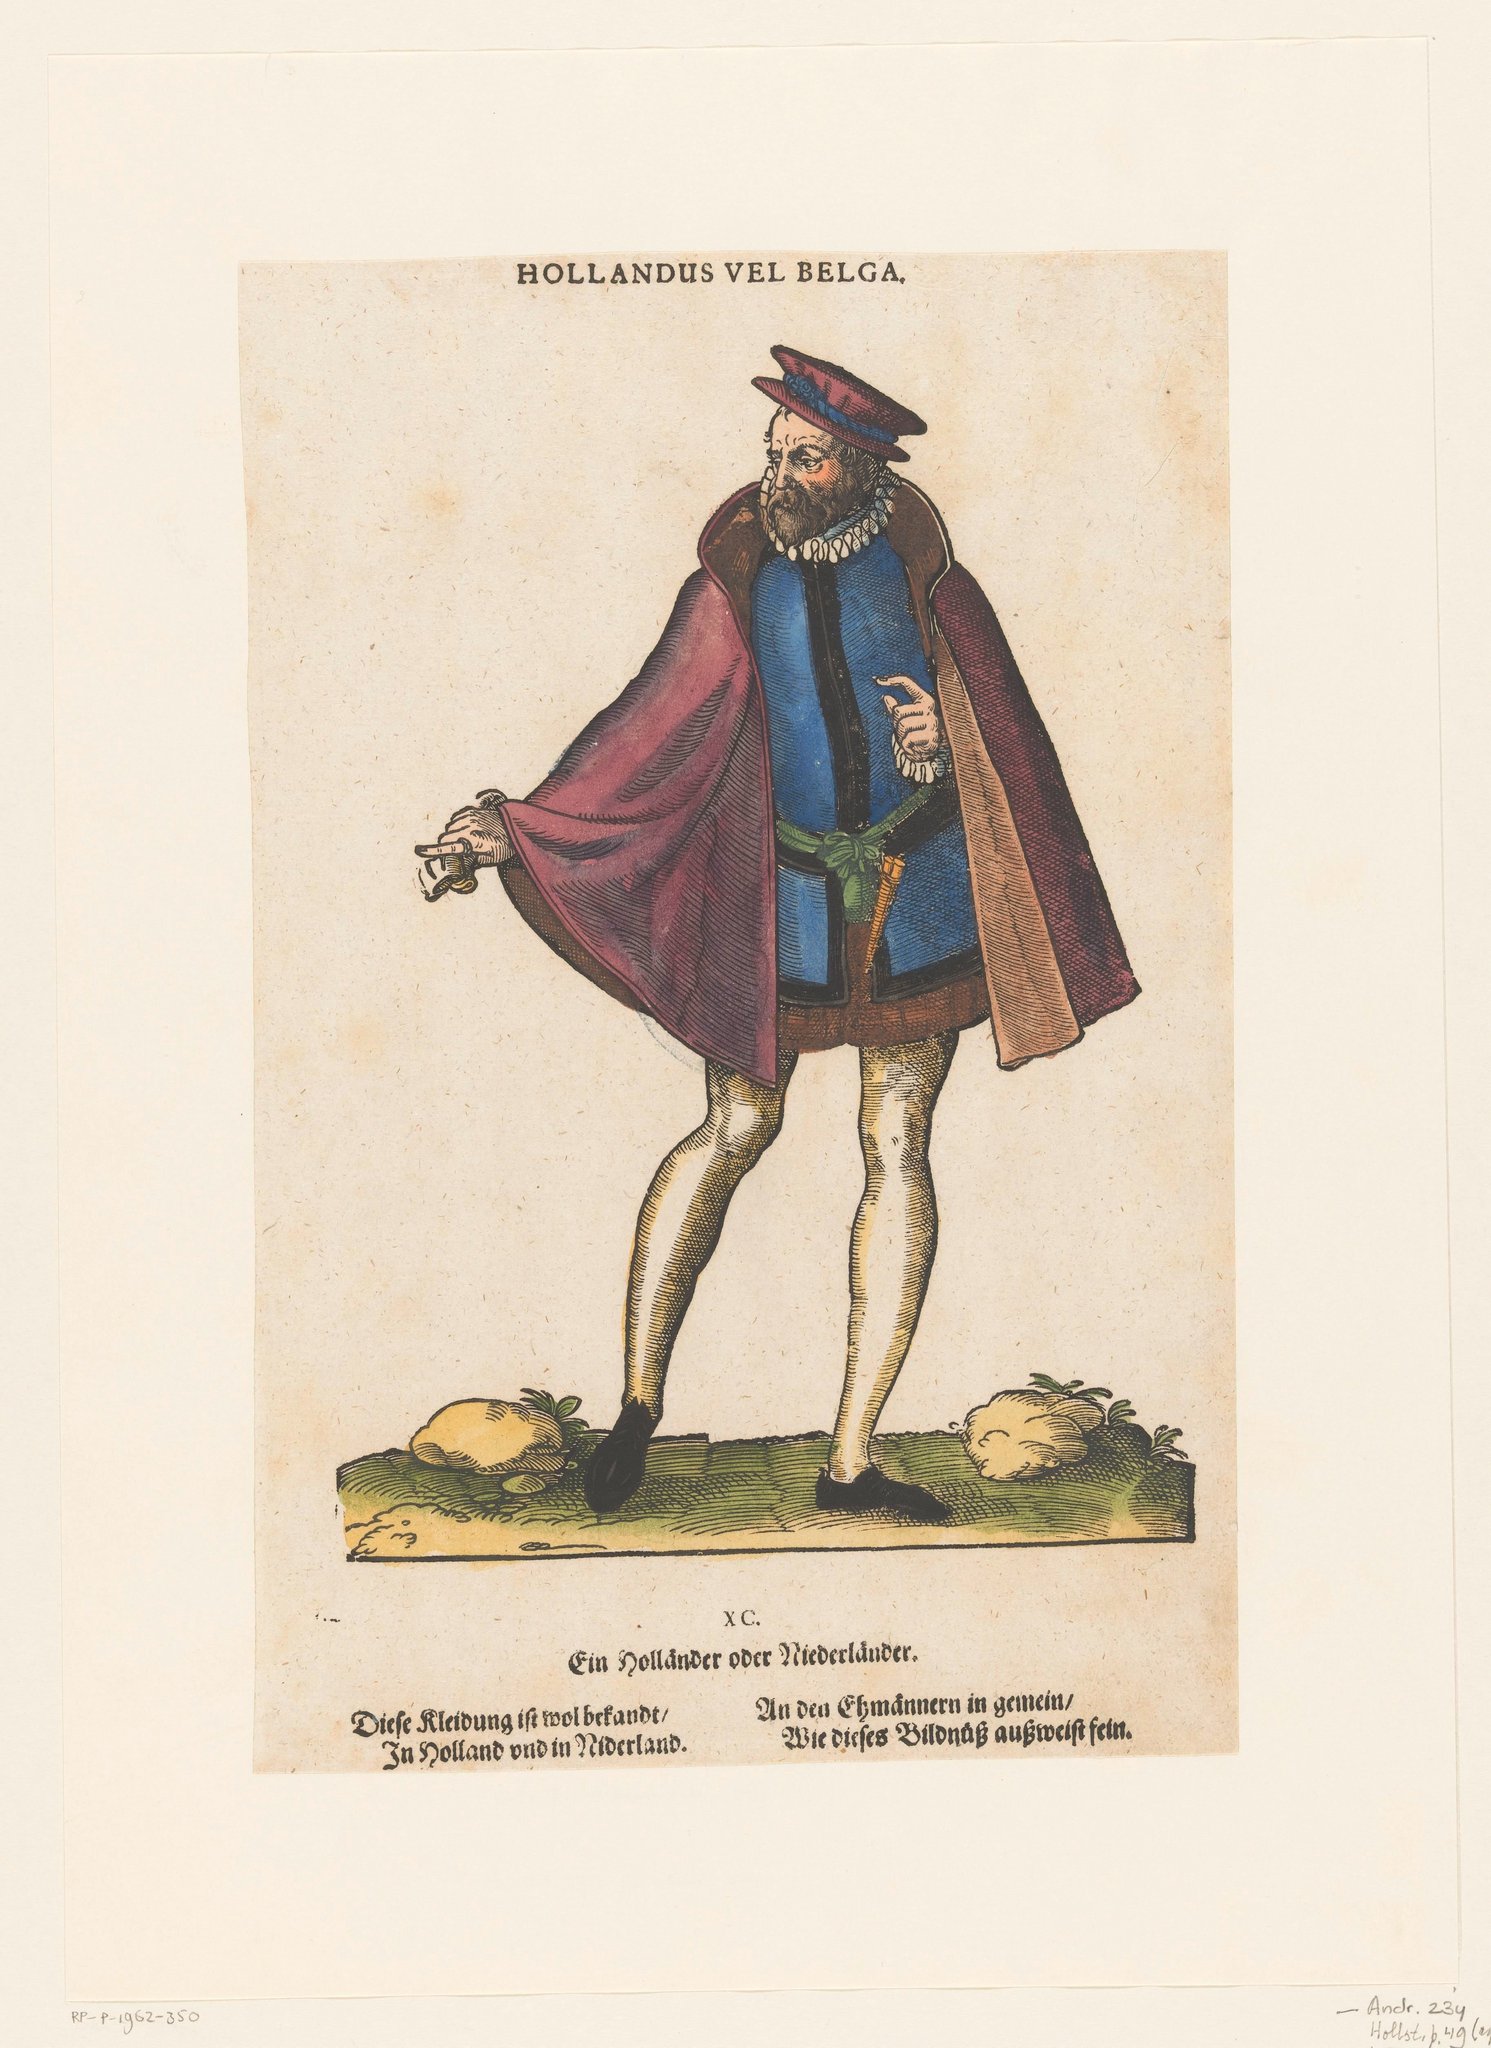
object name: print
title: Hollandus vel Belga / Ein Holländer oder Niederlander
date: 1577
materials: paper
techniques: hand coloring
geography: nuremberg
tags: neck-gear ~ clothing (with name) (+ men's clothes), cape, head-gear: hat (+ men's clothes), fashion plates, shoes, sandals (+ men's clothes), trousers, breeches, etc. (breeches) (+ men's clothes), clothing for the upper part of the body (doublet) (+ men's clothes), gloves, mittens, etc. (+ men's clothes)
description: De man draagt een schoudercape over zijn wambuis, een plooikraag en een korte pofbroek, geheel volgens de Spaanse mode van die tijd. In zijn hand houdt hij een handschoen. Genummerd midden onder: XC.